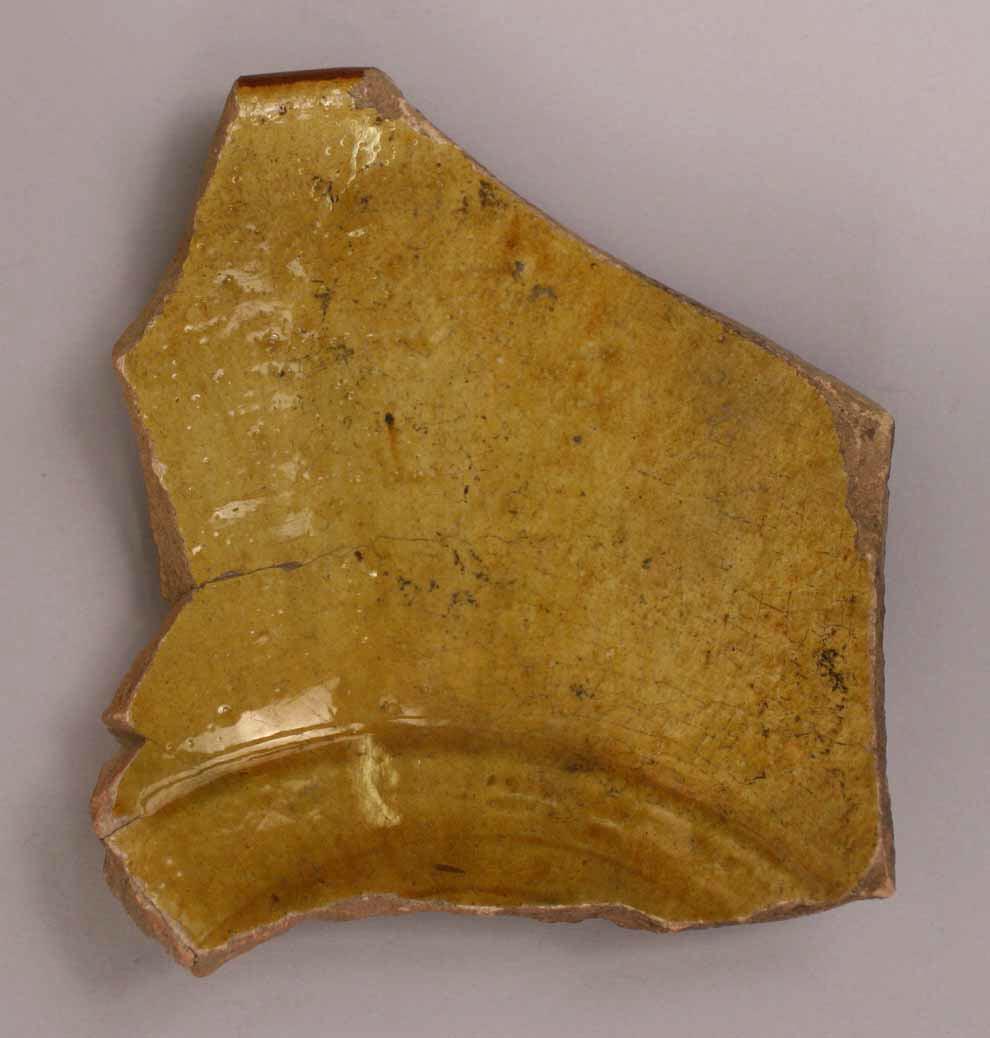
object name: fragment of a bowl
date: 1501-1700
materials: earthenware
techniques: glazing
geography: iran